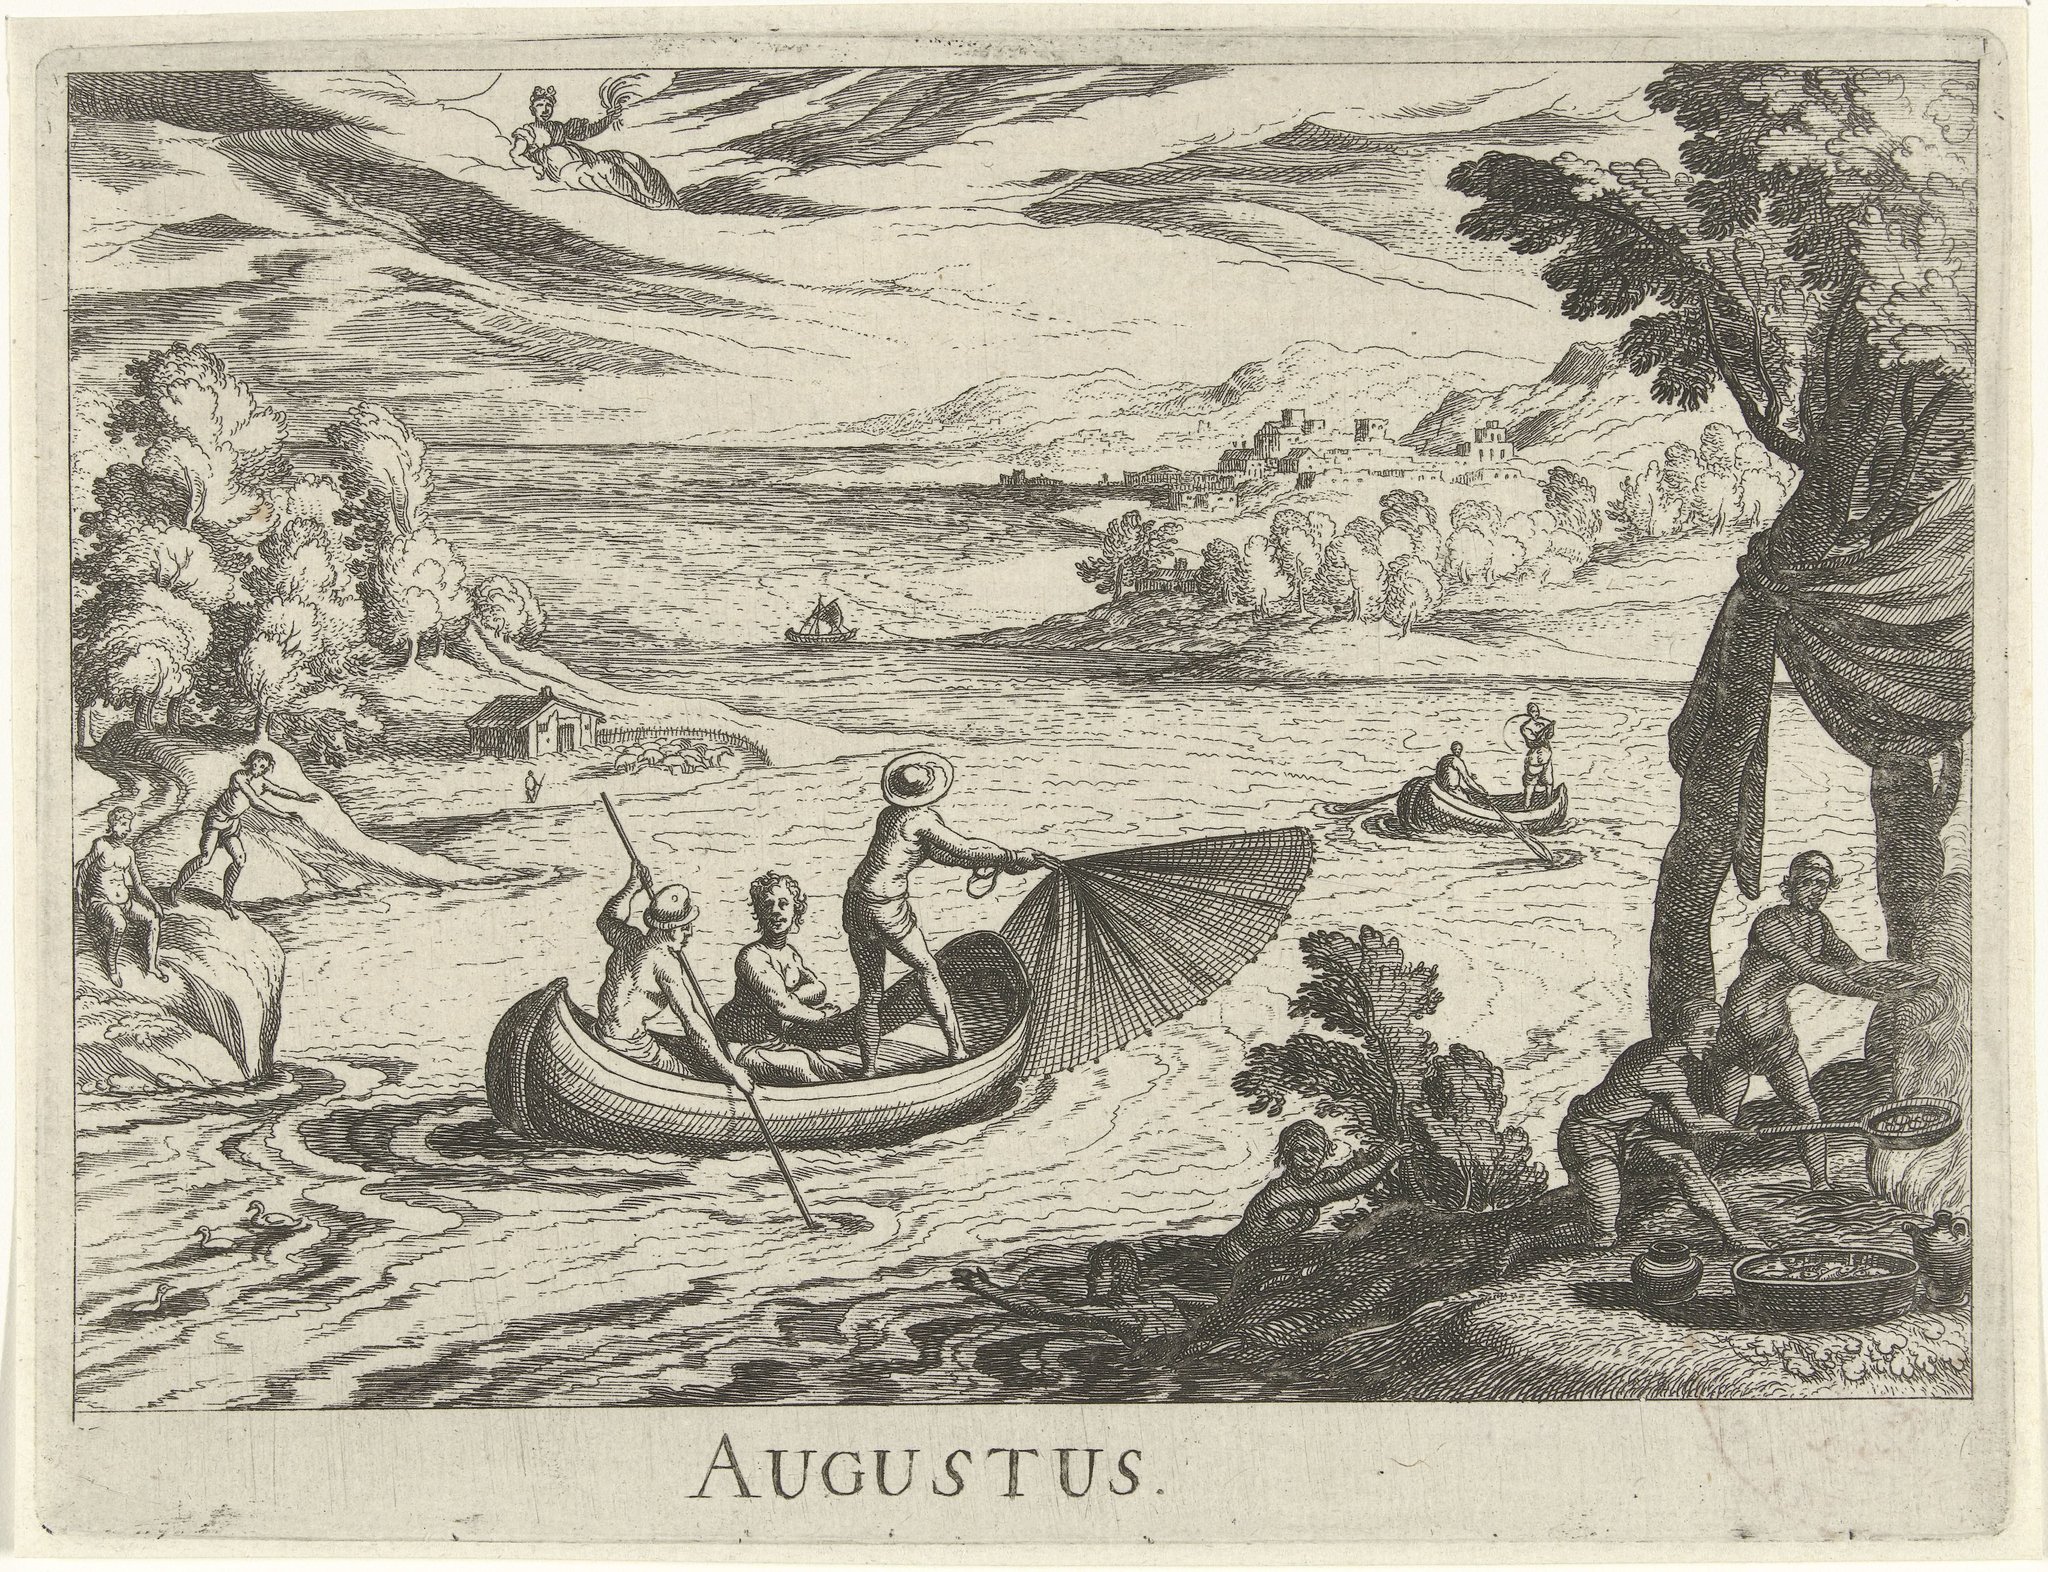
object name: print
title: Twaalf maanden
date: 1611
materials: paper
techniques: etching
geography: the hague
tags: landscape symbolizing august (+ with signs or personifications of the planets)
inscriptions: collector's mark: Lugt 240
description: De maand augustus wordt voorgesteld door een rivierlandschap met vissers. Op de achtergrond is in de lucht het sterrenbeeld Maagd weergegeven.